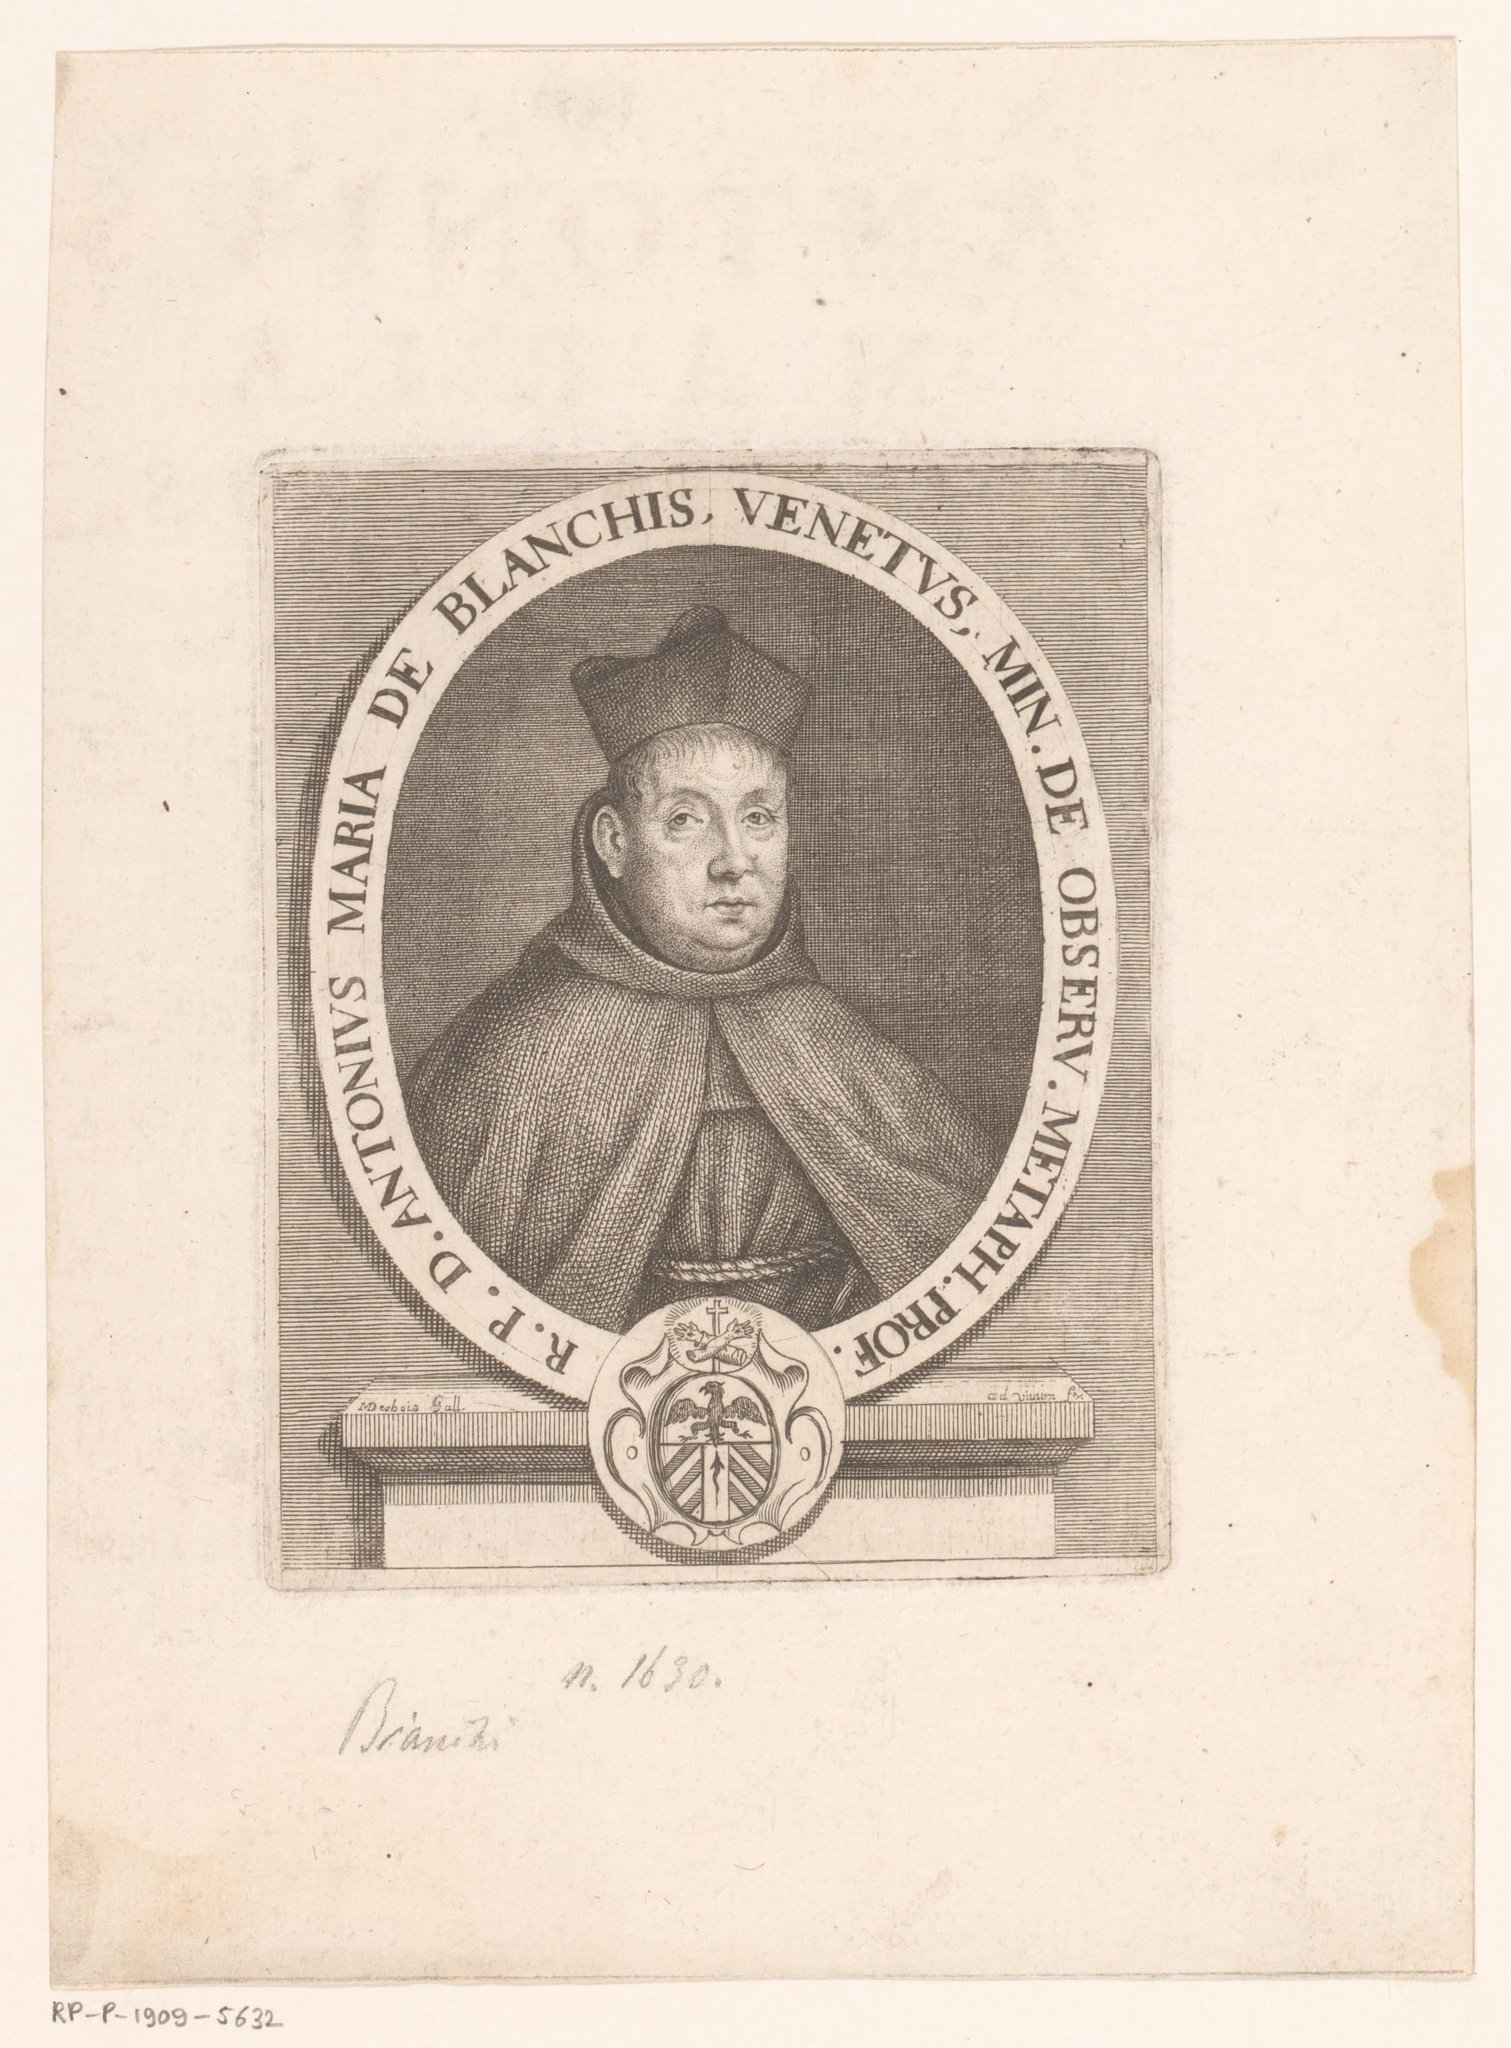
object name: book illustration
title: Portret van Antonio Maria de Blanchis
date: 1682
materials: paper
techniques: engraving, etching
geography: padua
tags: historical persons, professor, armorial bearing, heraldry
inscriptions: collector's mark: Lugt 2228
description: Prent uit: Patin, Charles. Lyceum Patavinum: sive icones et vitae professorum. Padua: Frambotti, Petri Mariae, 1682.